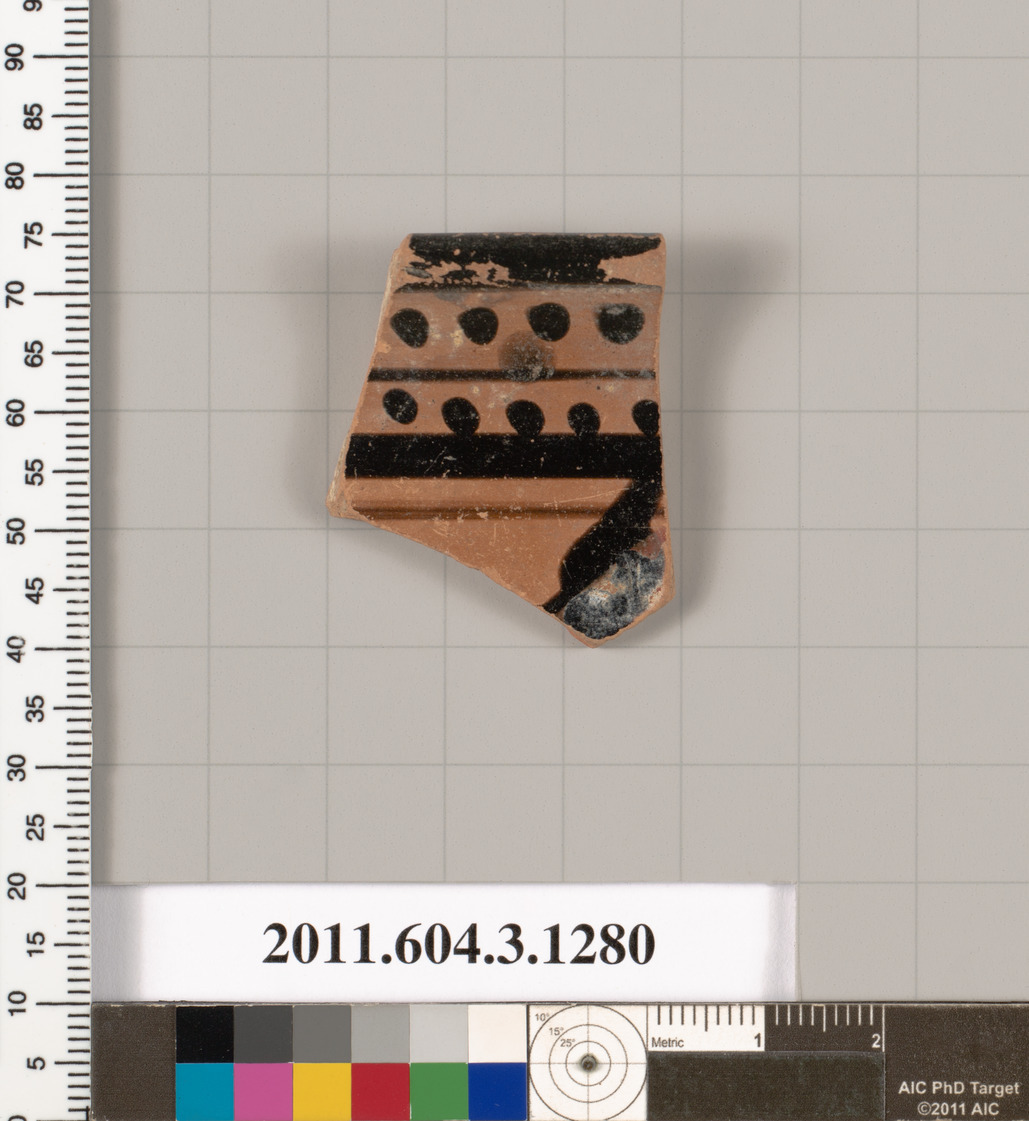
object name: skyphos fragment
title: Terracotta rim fragment of a skyphos (deep drinking cup)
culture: greek, attic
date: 500 BCE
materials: terracotta